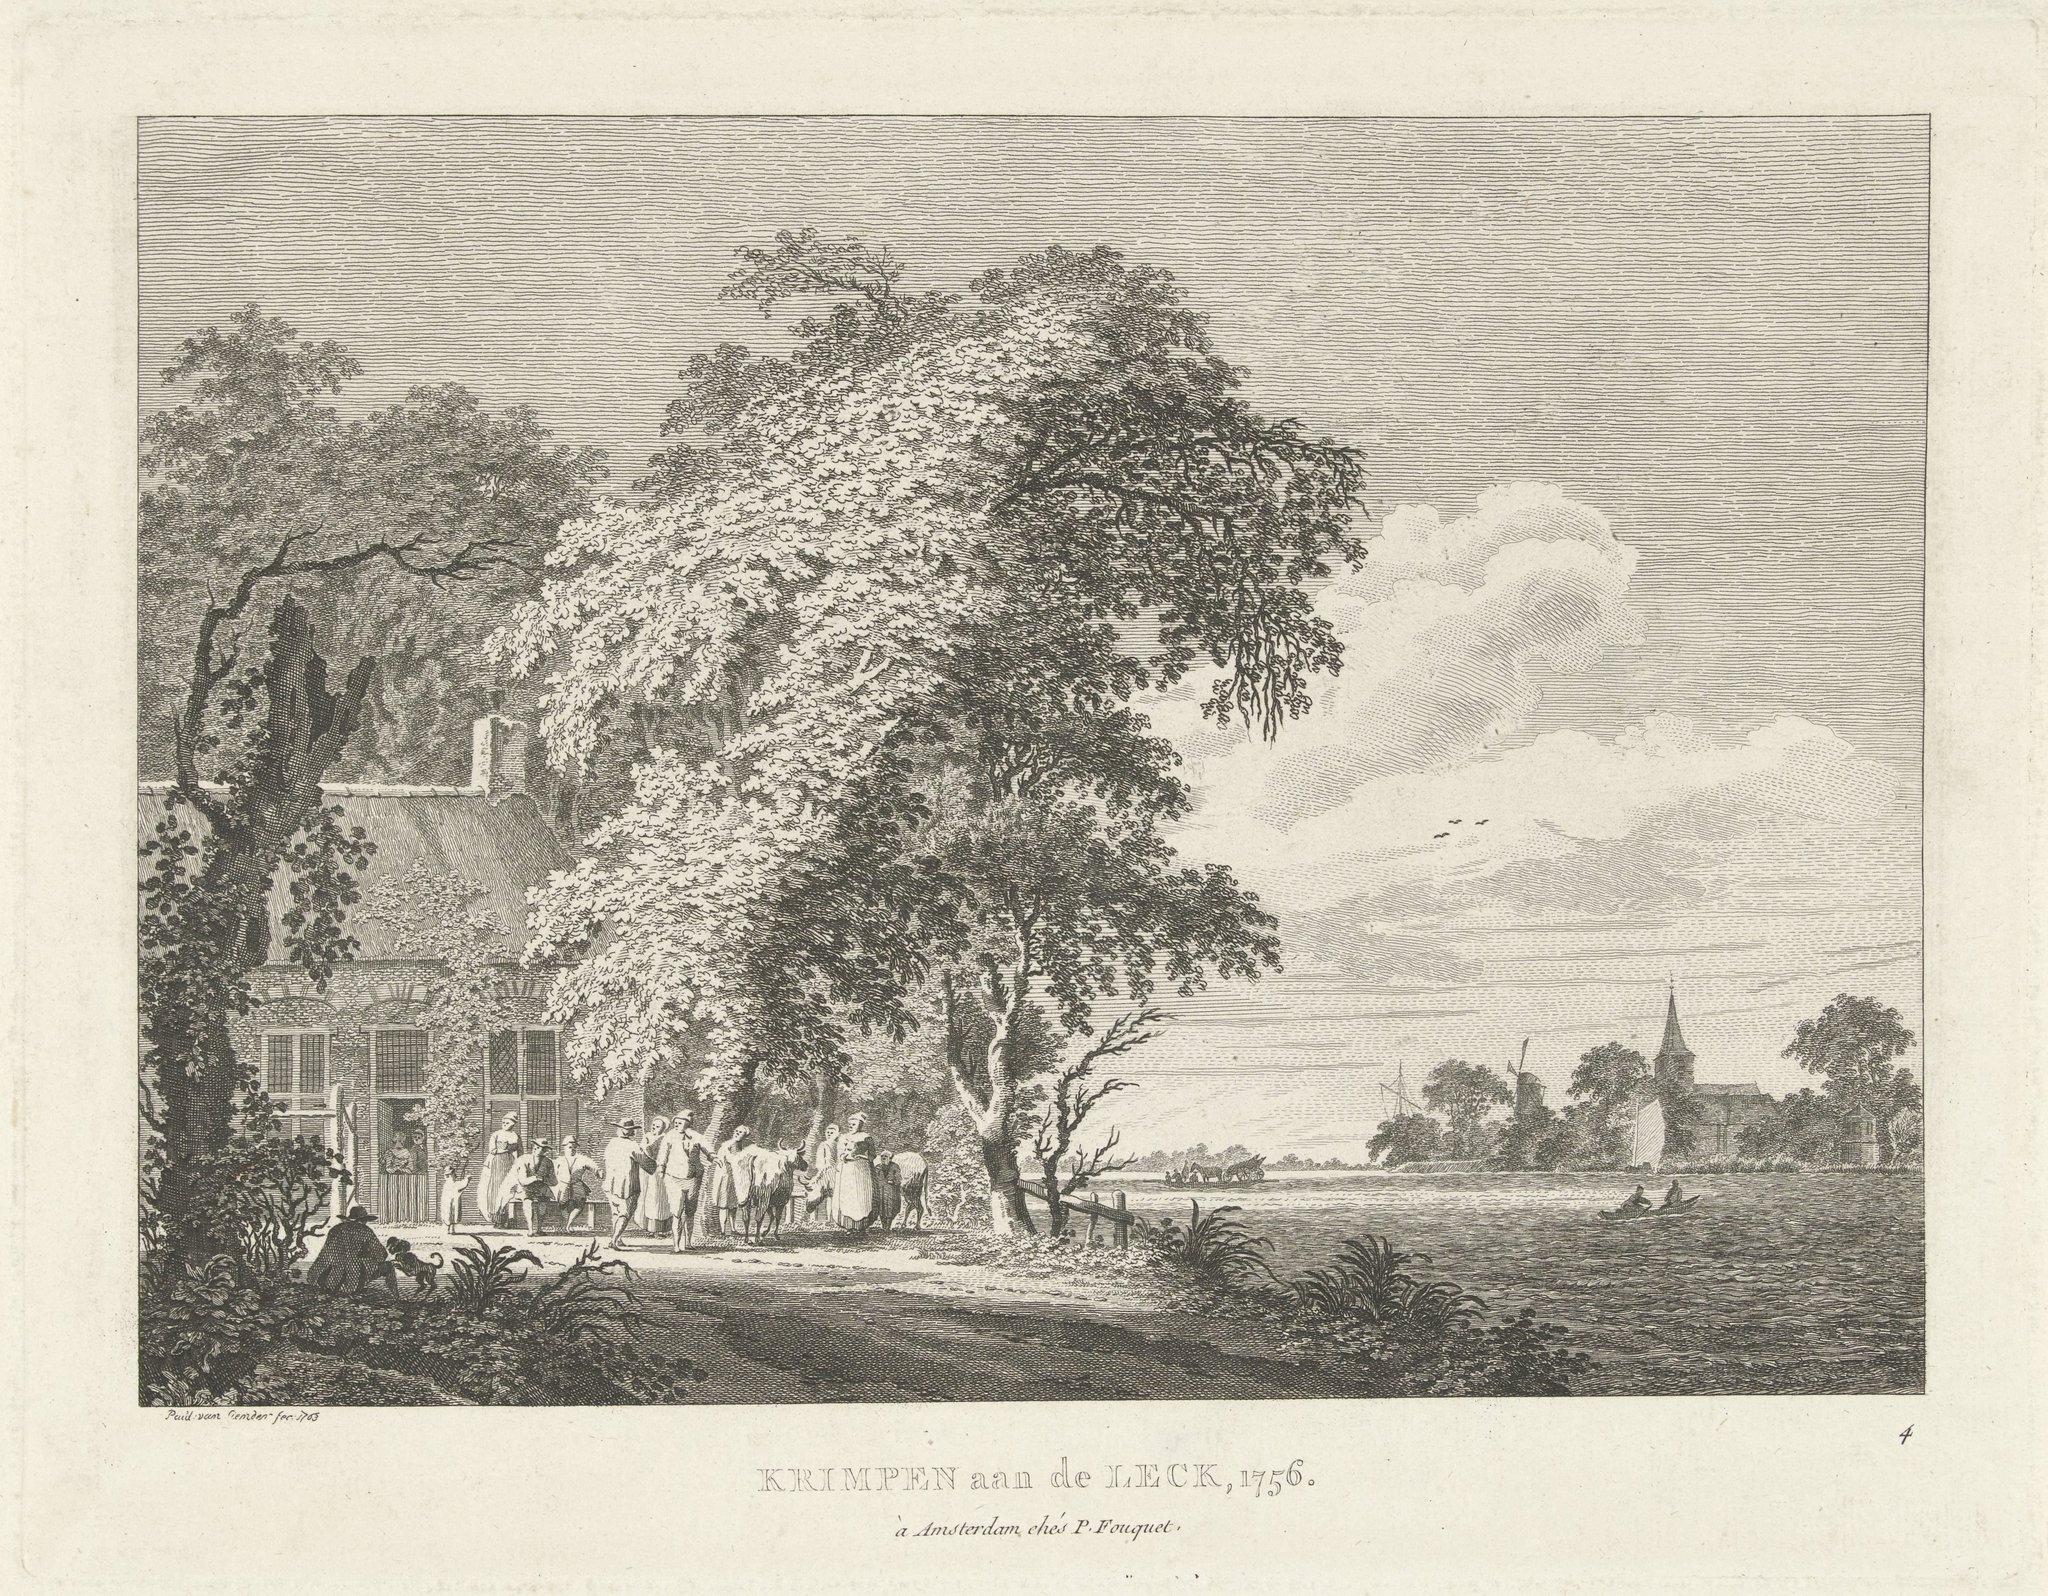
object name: print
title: Krimpen aan de Leck, 1756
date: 1763-1796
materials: paper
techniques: etching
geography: amsterdam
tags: landscapes with waters, waterscapes, seascapes (in the temperate zone), village, ferry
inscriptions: collector's mark: Lugt 240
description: Gezicht op het veerhuis in het dorp Krimpen aan de Lek met figuren en dieren op het erf. Op de Lek varen een veerboot en roeiboot, aan de overzijde ligt de dorpskern. Prent rechtsonder genummerd: 4.